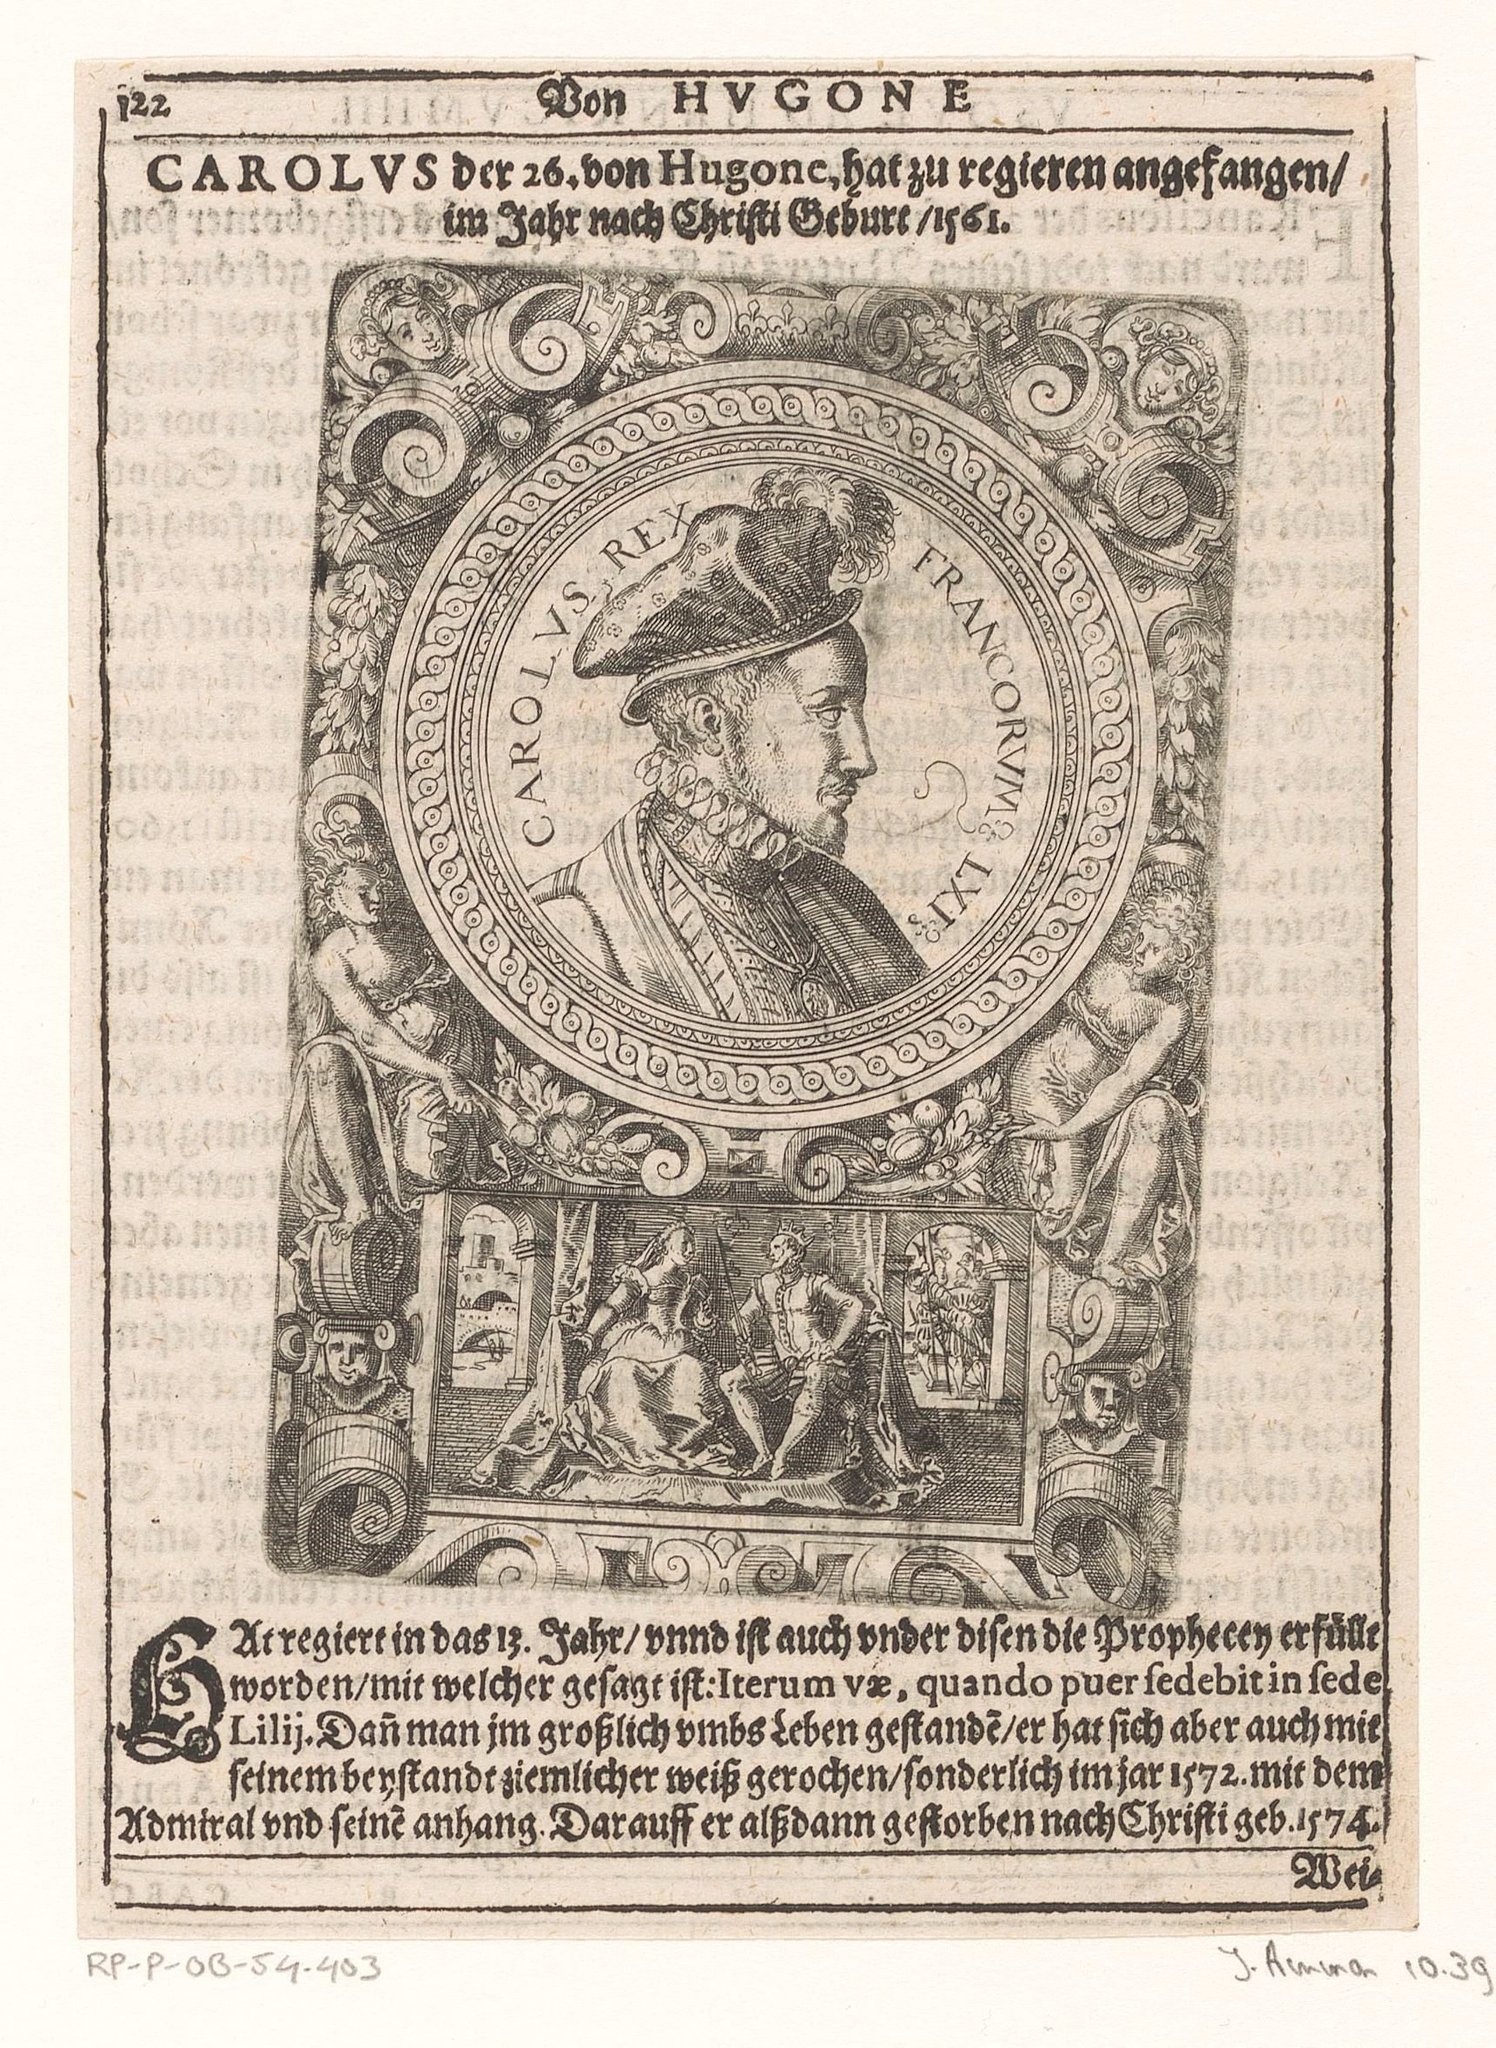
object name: book illustration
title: Portret van Karel IX, koning van Frankrijk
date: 1598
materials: paper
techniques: etching, intaglio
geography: nuremberg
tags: karel ix (koning van frankrijk), scrollwork, strapwork ~ ornament, historical persons, ruler, sovereign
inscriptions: collector's mark: Lugt 2228, number: ‘158’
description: Prent afkomstig uit de publicatie: Michael Eizinger. Könige in Frankreich. Keulen: Johann Bussemacher, 1598, p. 122. De publicatie bevat prenten van Jost Amman en Virgil Solis.